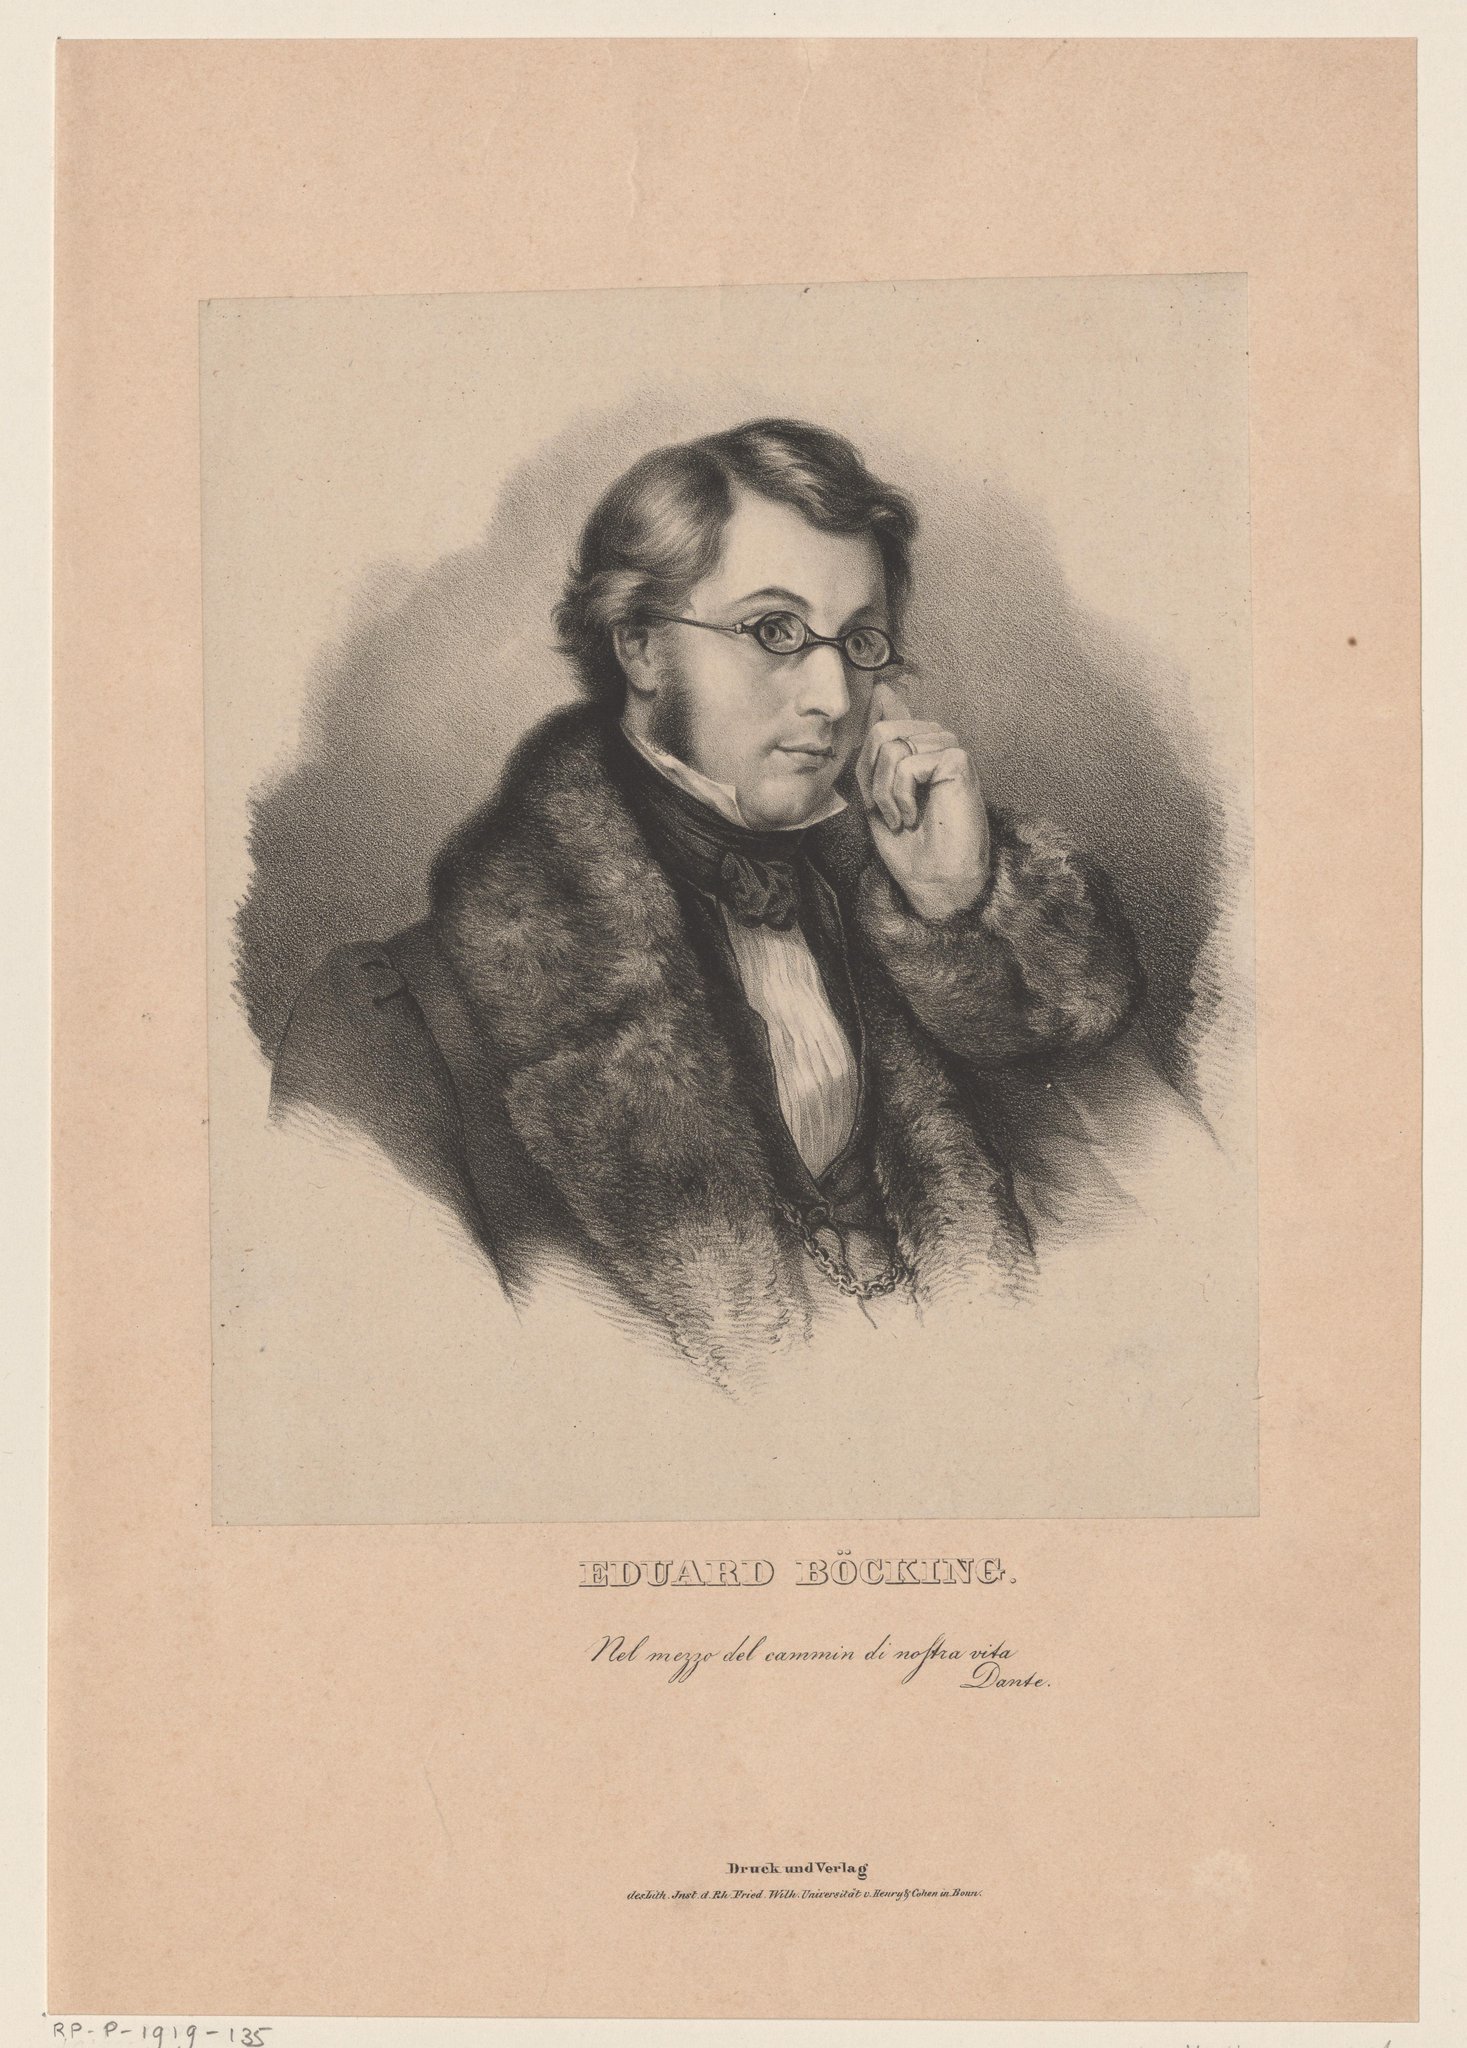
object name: print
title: Portret van Eduard Böcking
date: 1830-1850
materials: paper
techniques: lithograph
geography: bonn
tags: scholar, philosopher, historical persons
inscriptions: collector's mark: Lugt 2228